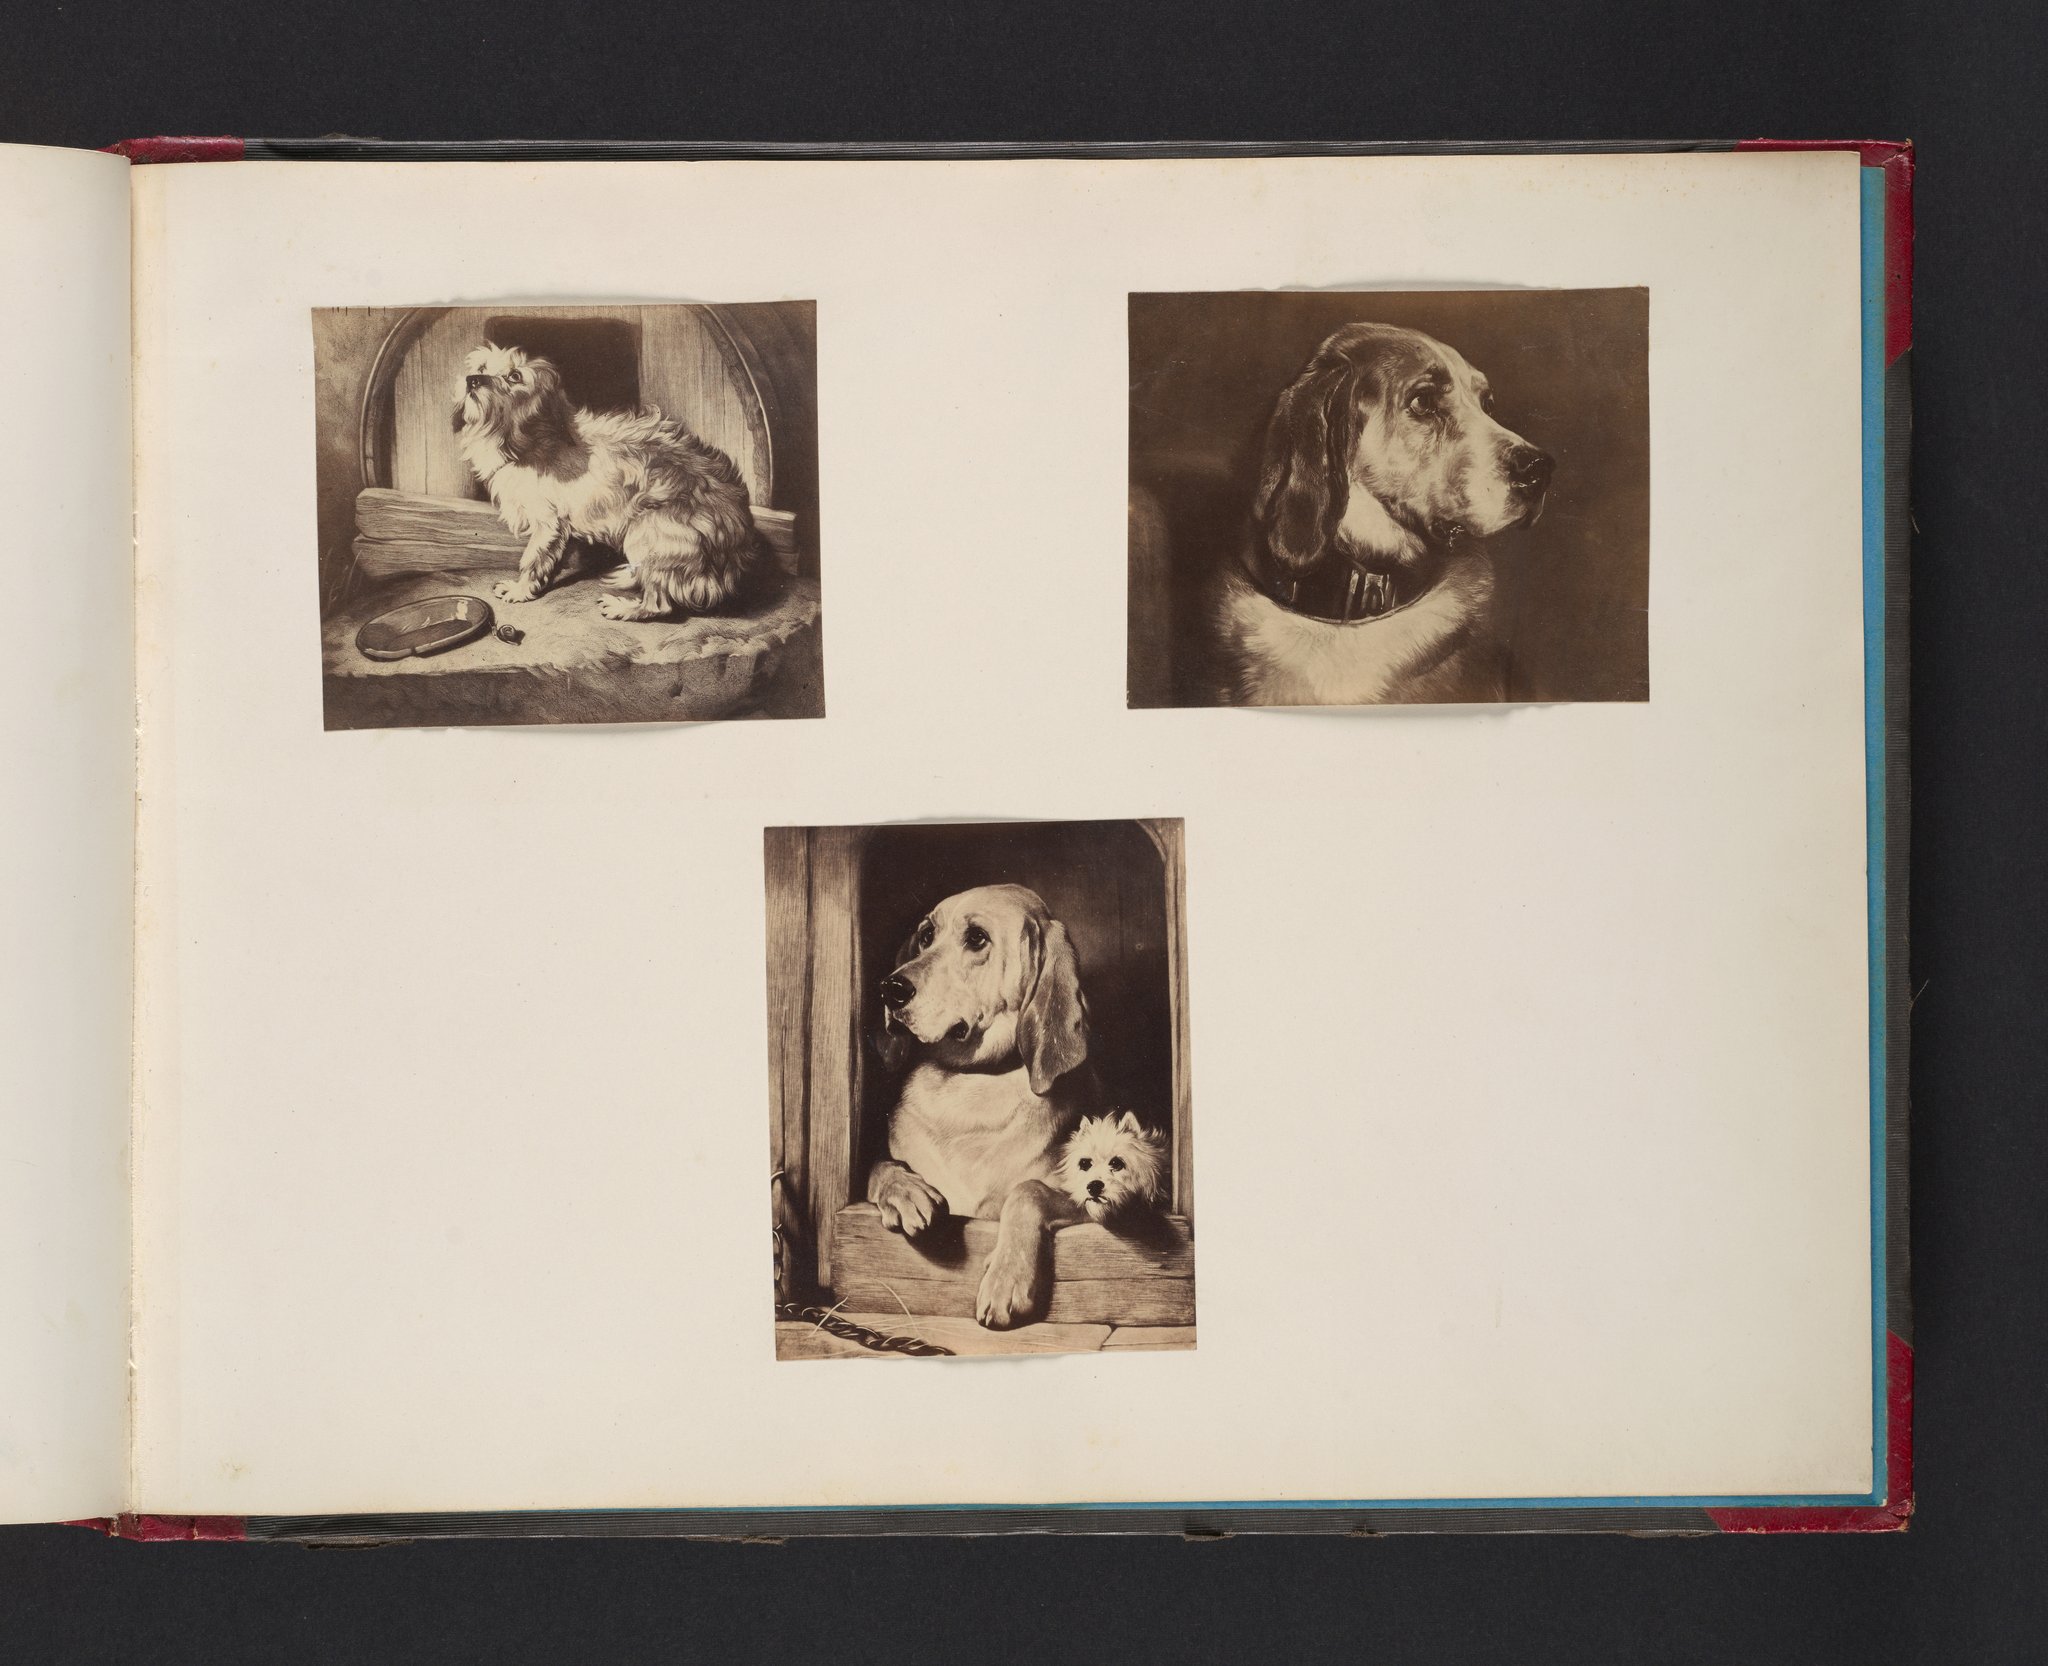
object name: photograph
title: [Dogs]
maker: john thomson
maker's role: artist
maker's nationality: british, scottish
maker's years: 1837-1921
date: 1865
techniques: albumen silver print, glass negative